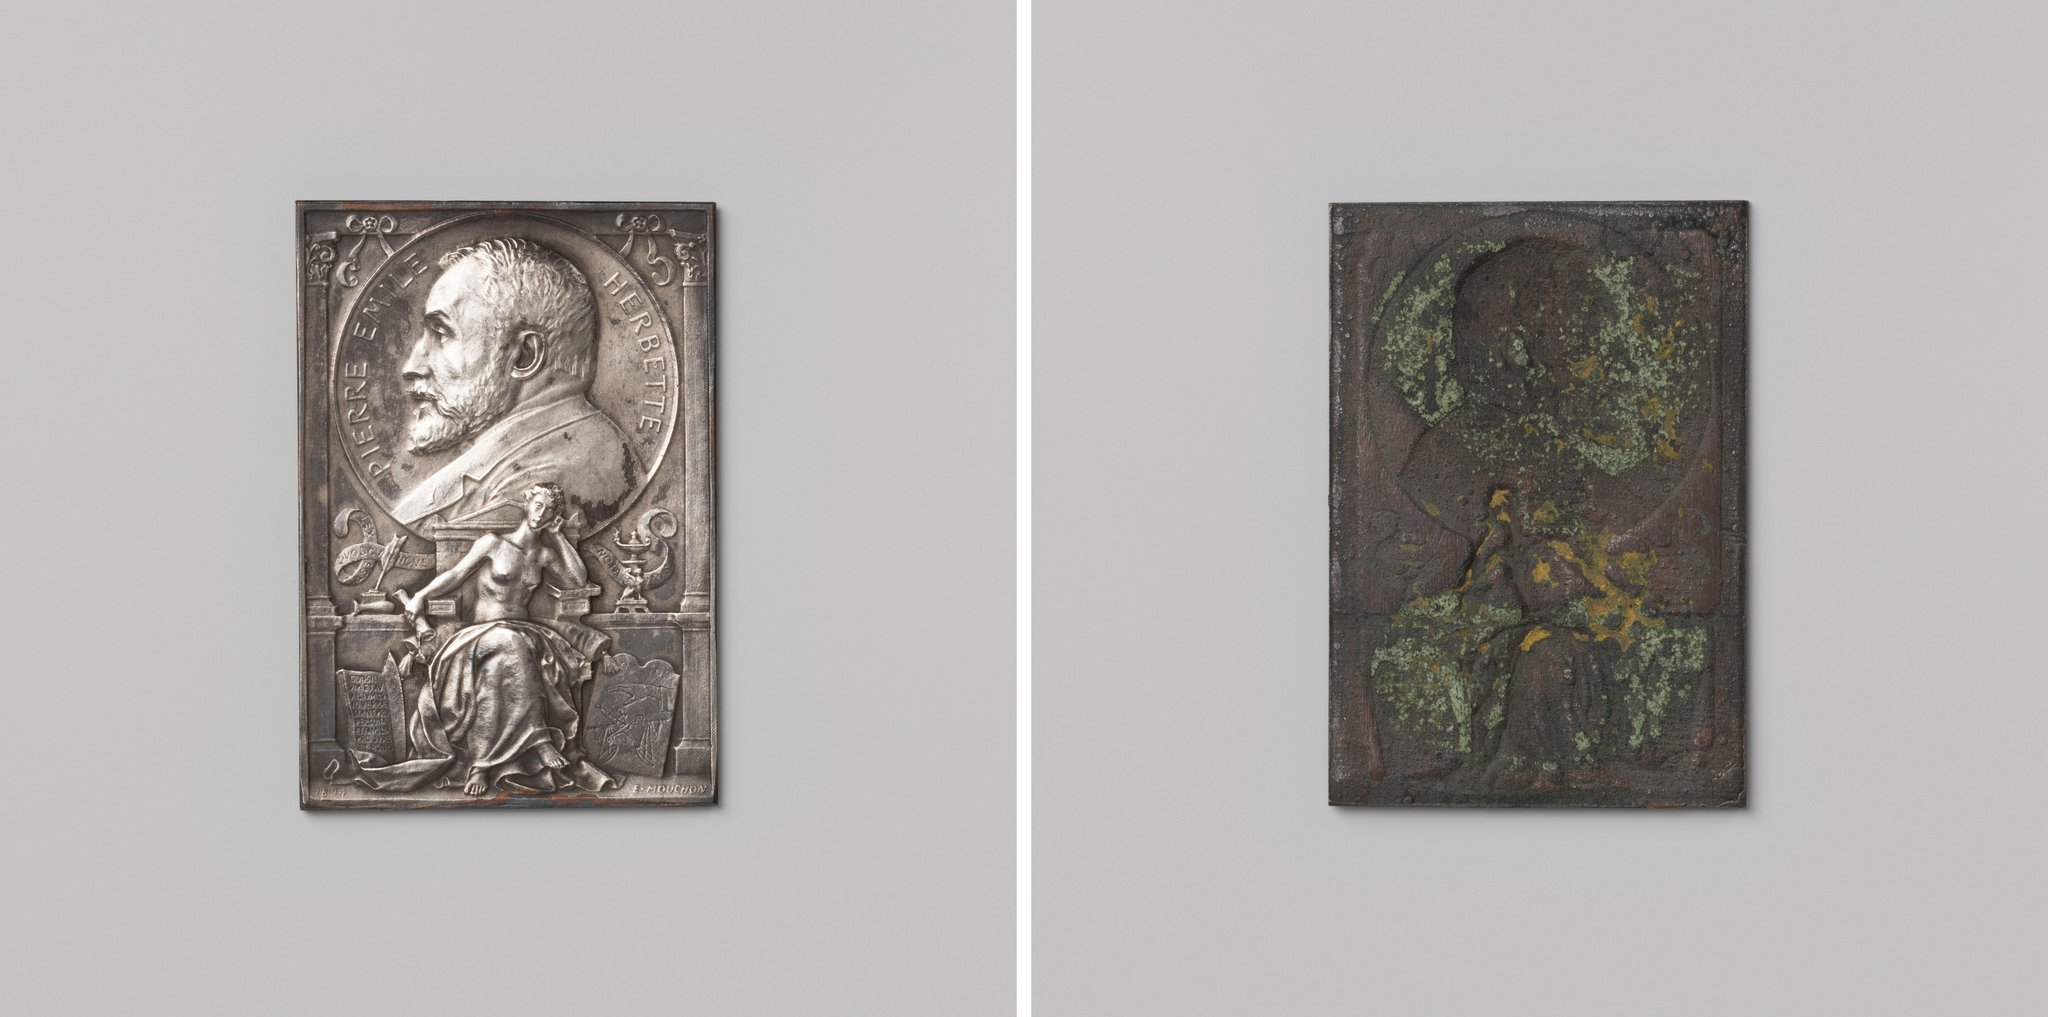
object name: honorary medal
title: Pierre Emile Herbette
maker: louis eugène mouchon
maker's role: medailleur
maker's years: 1843-1914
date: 1894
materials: silver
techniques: casting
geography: paris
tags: pierre emile herbette